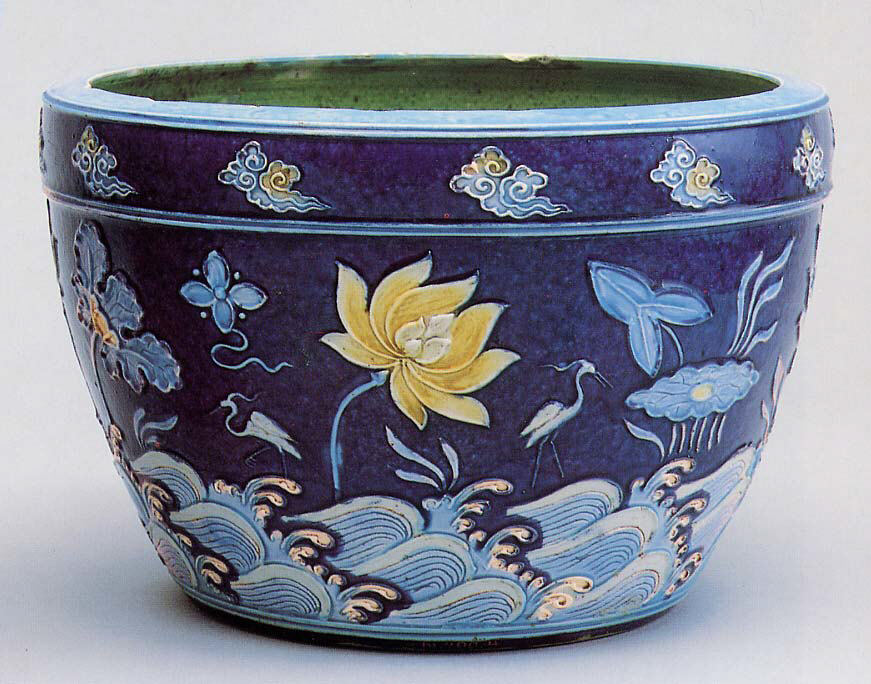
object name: basin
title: Basin with lotus pond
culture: chinese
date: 1467-1500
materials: enamel, porcelain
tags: birds,lotuses